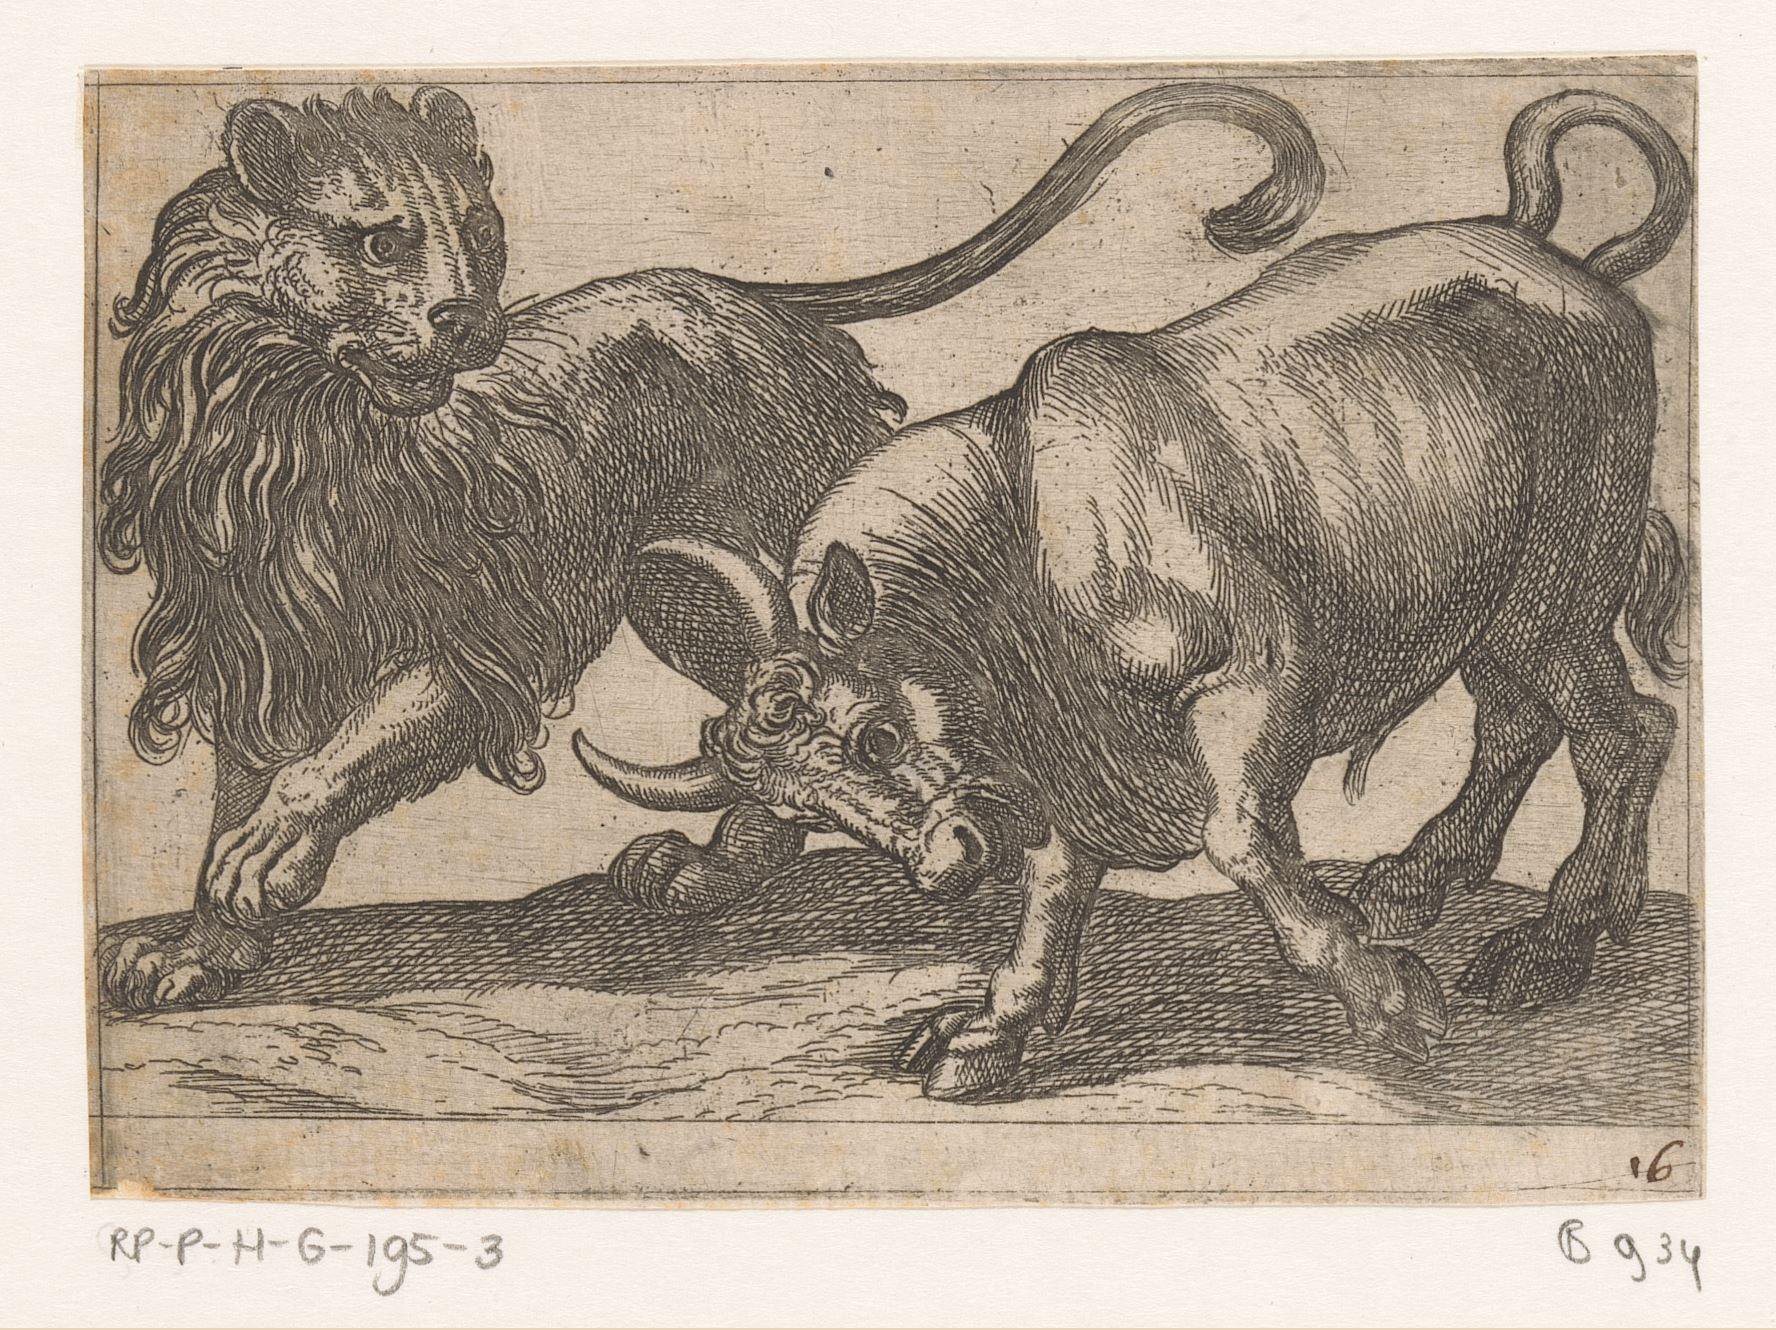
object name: print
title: Vechtende dieren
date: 1600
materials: paper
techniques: etching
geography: vatican city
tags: bull, beasts of prey, predatory animals: lion, fighting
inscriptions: collector's mark: ‘Hinloopen’, number: ‘16’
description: Deze prent maakt deel uit van een reeks van 25 prenten (+ titelprent) van vechtende dieren.